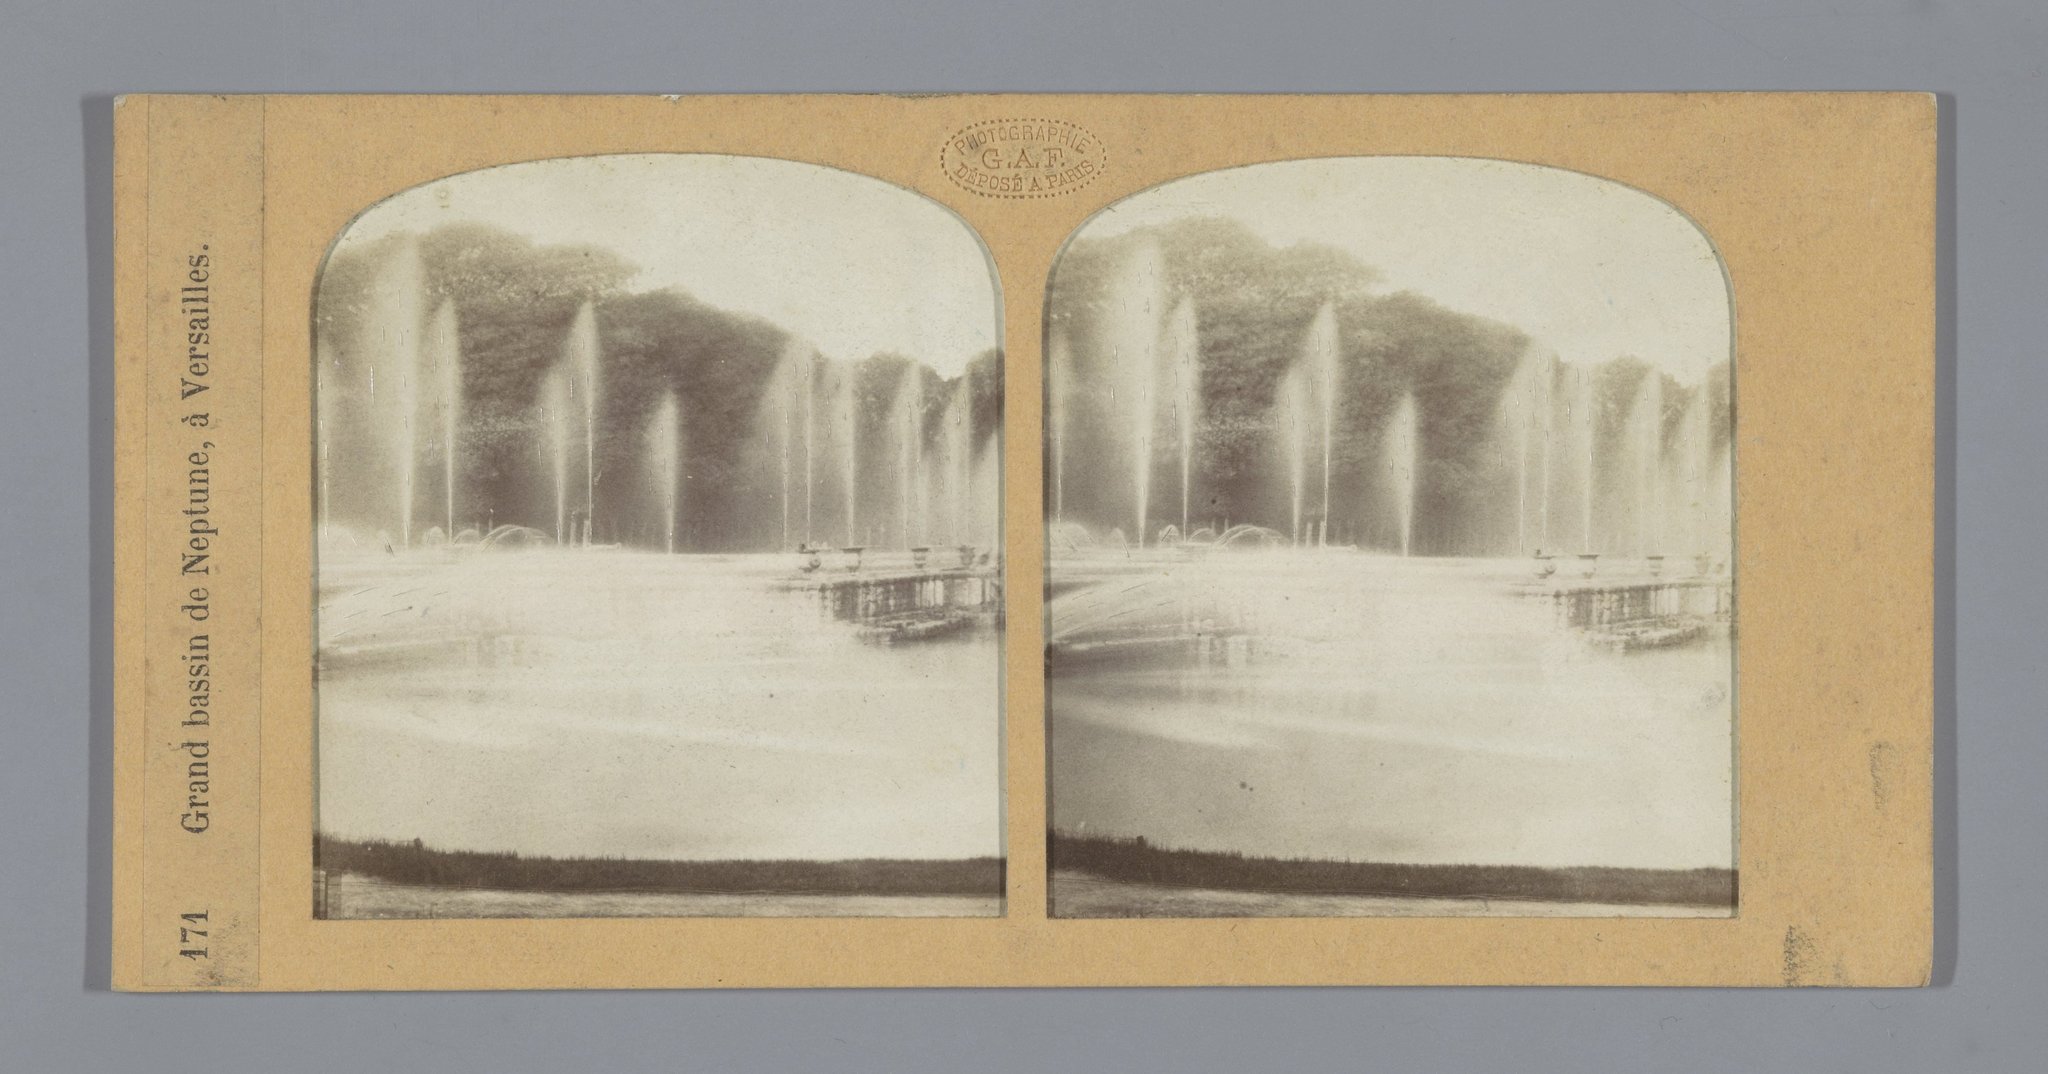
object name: tissue stereograph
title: Grand bassin de Neptune, à Versailles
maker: florent grau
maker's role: manufacturer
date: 1858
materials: cardboard, paper, photographic support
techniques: albumen print, cutting, hand coloring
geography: versailles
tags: garden fountain, garden pond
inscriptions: check stamp: ‘PHOTOGRAPHIE/ G.A.P./ DÉPOSÉ A PARIS’, number: ‘171’